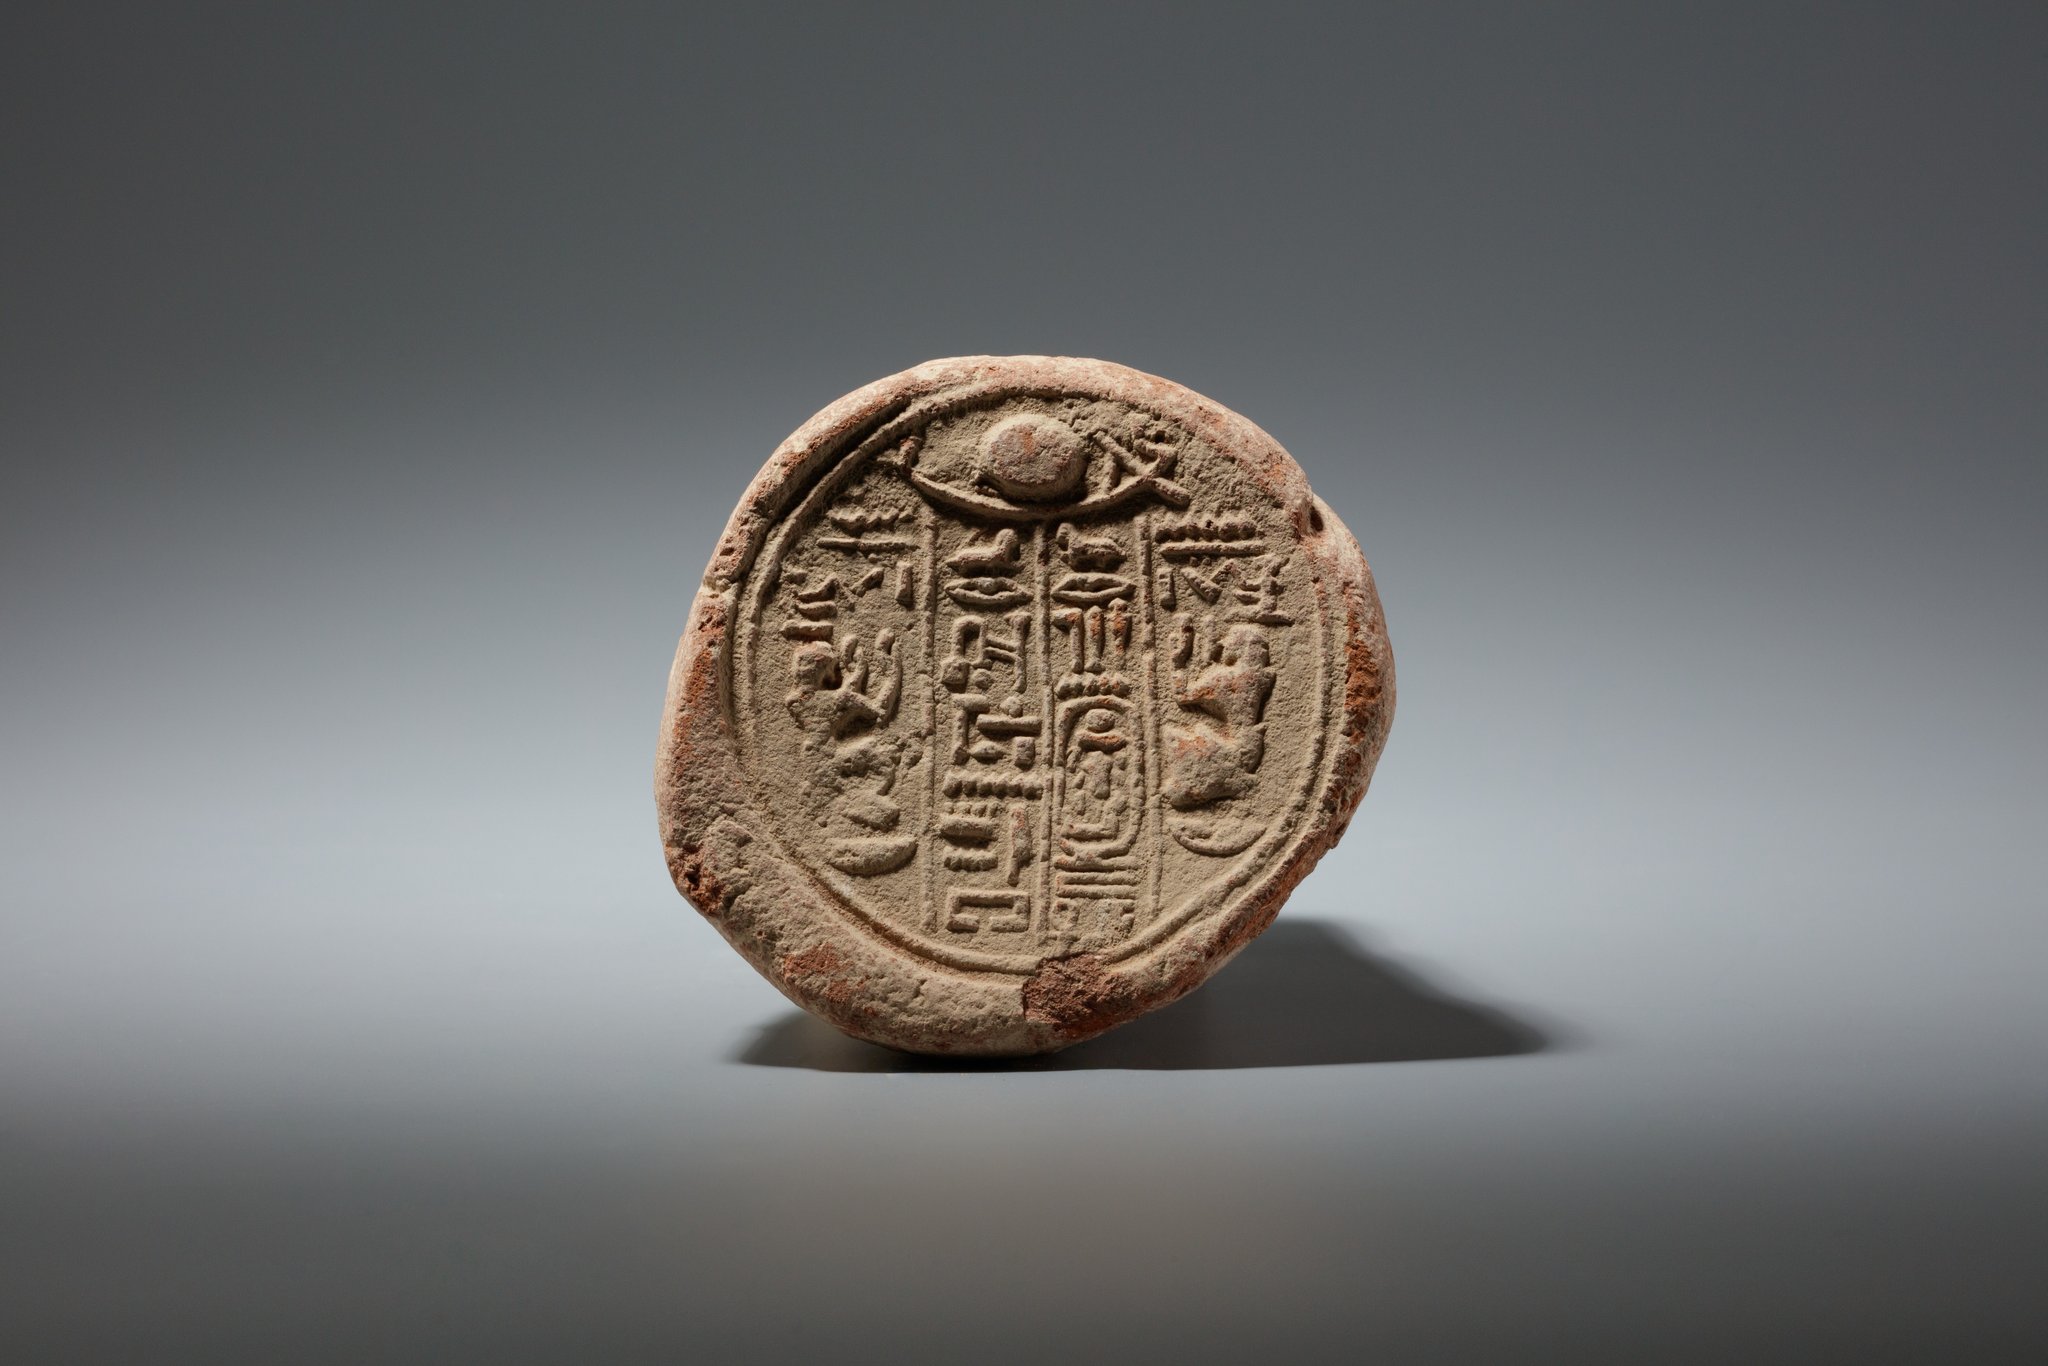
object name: cone, davy 605, neta, scribe, prophet, thutmose i, amun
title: Funerary Cone of the Scribe Neta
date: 1390-1213 BCE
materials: pottery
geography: egypt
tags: hieroglyphs